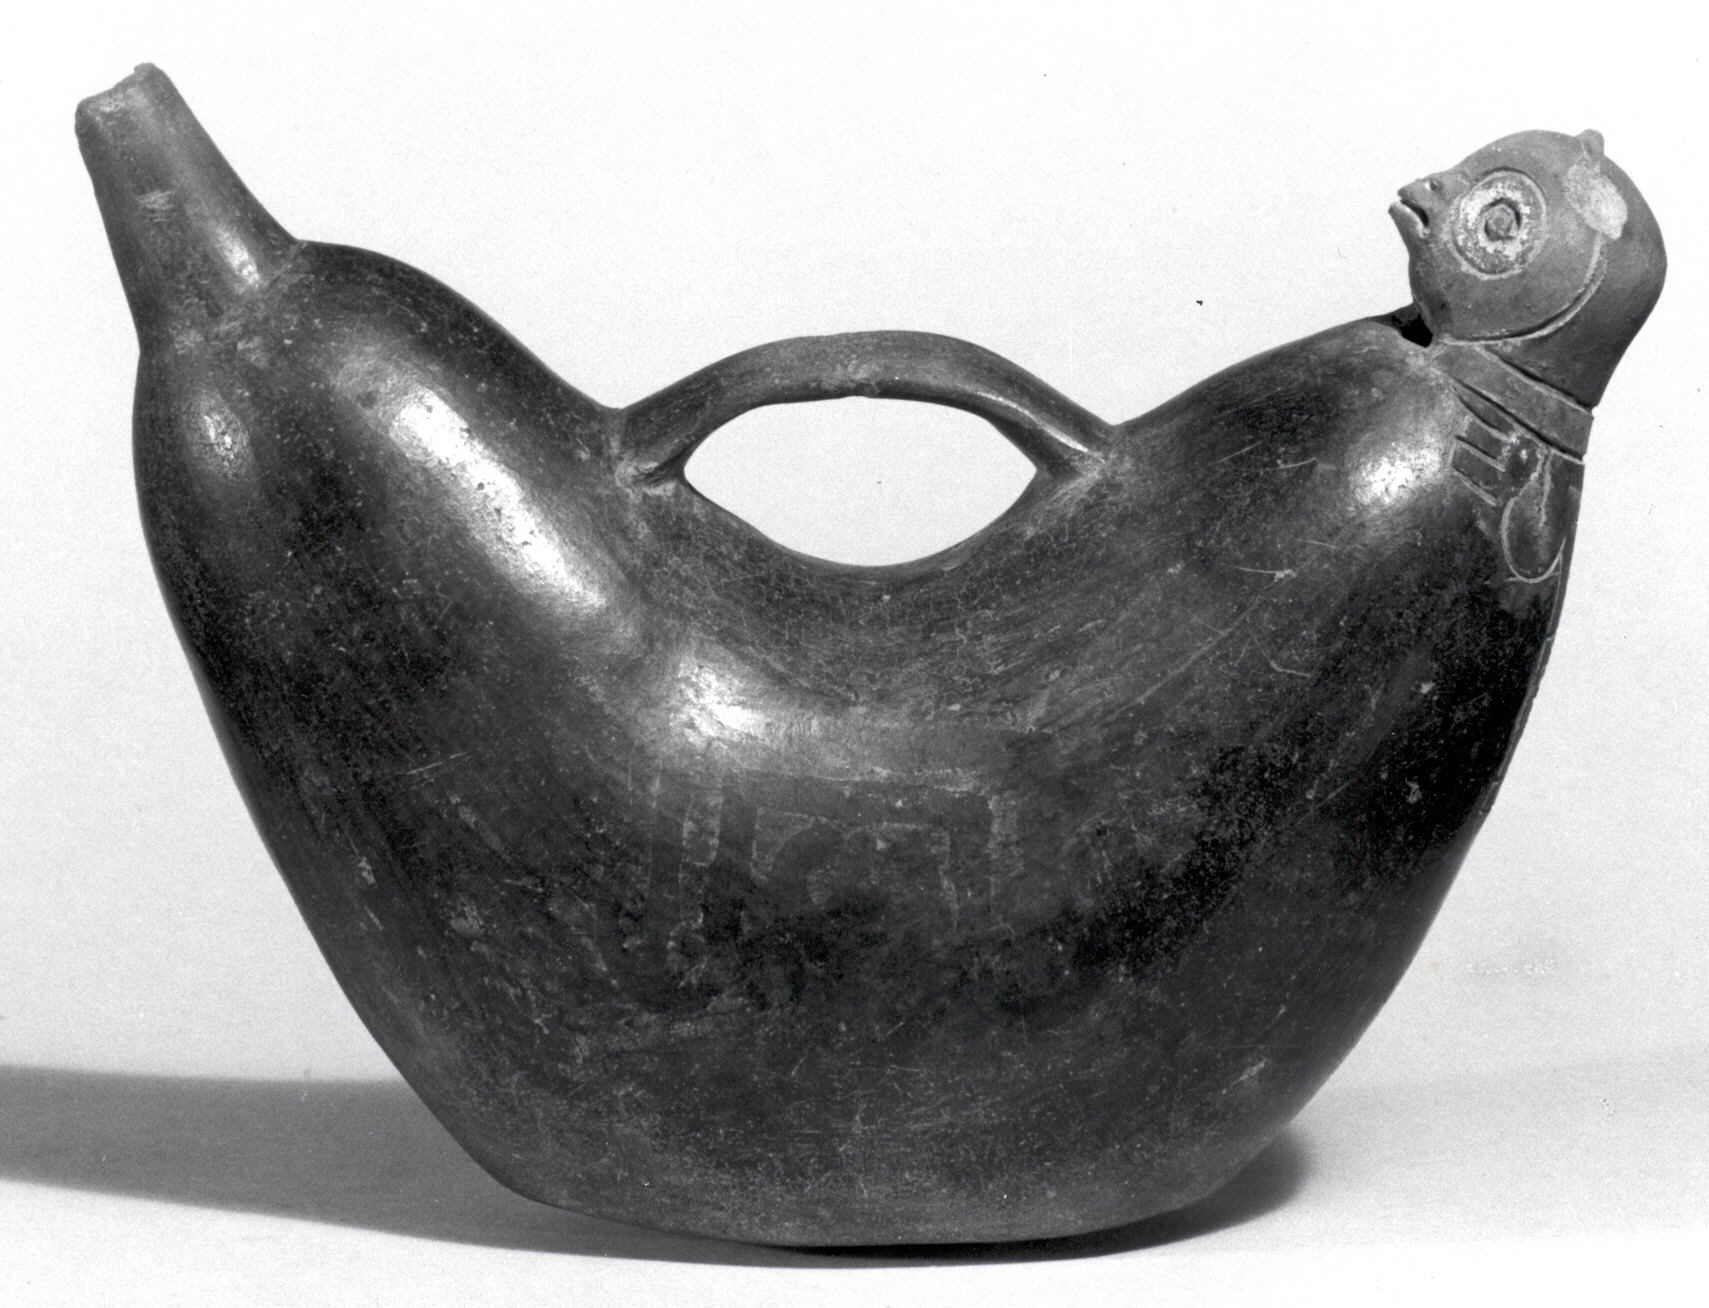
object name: bottle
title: Bird-Head Vessel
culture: paracas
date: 500-301 BCE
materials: ceramic, pigment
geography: peru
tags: birds